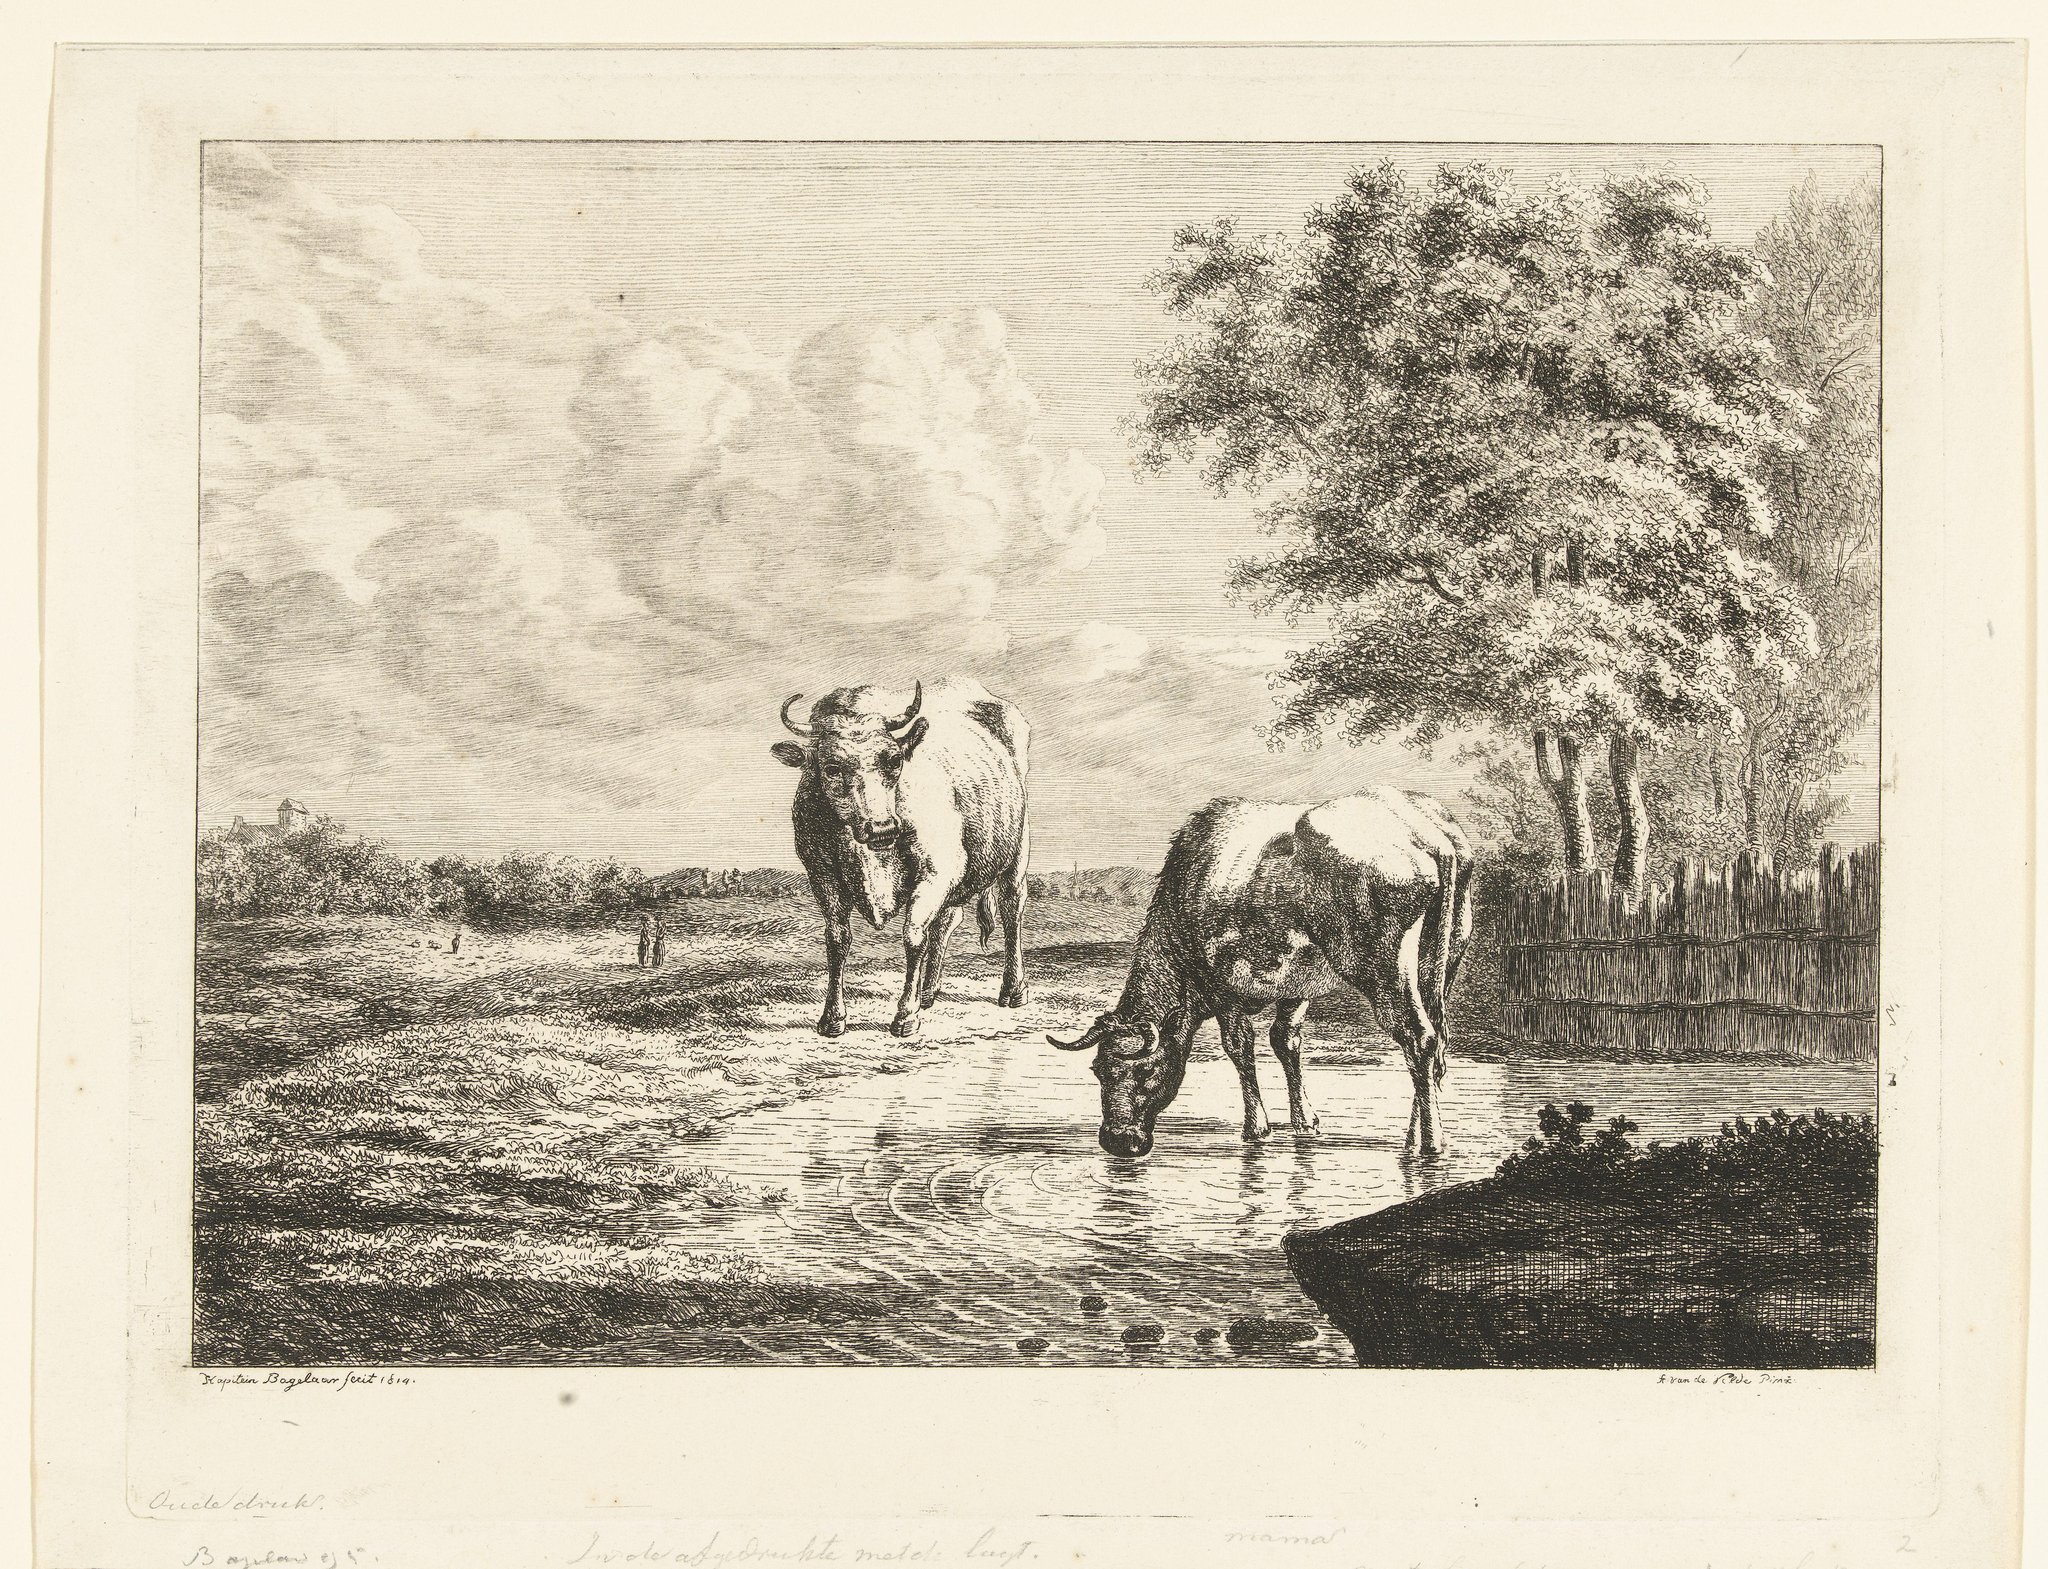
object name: print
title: Twee koeien in een waterplas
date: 1814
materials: paper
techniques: drypoint, etching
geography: netherlands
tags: bovine cattle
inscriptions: collector's mark: Lugt 2228